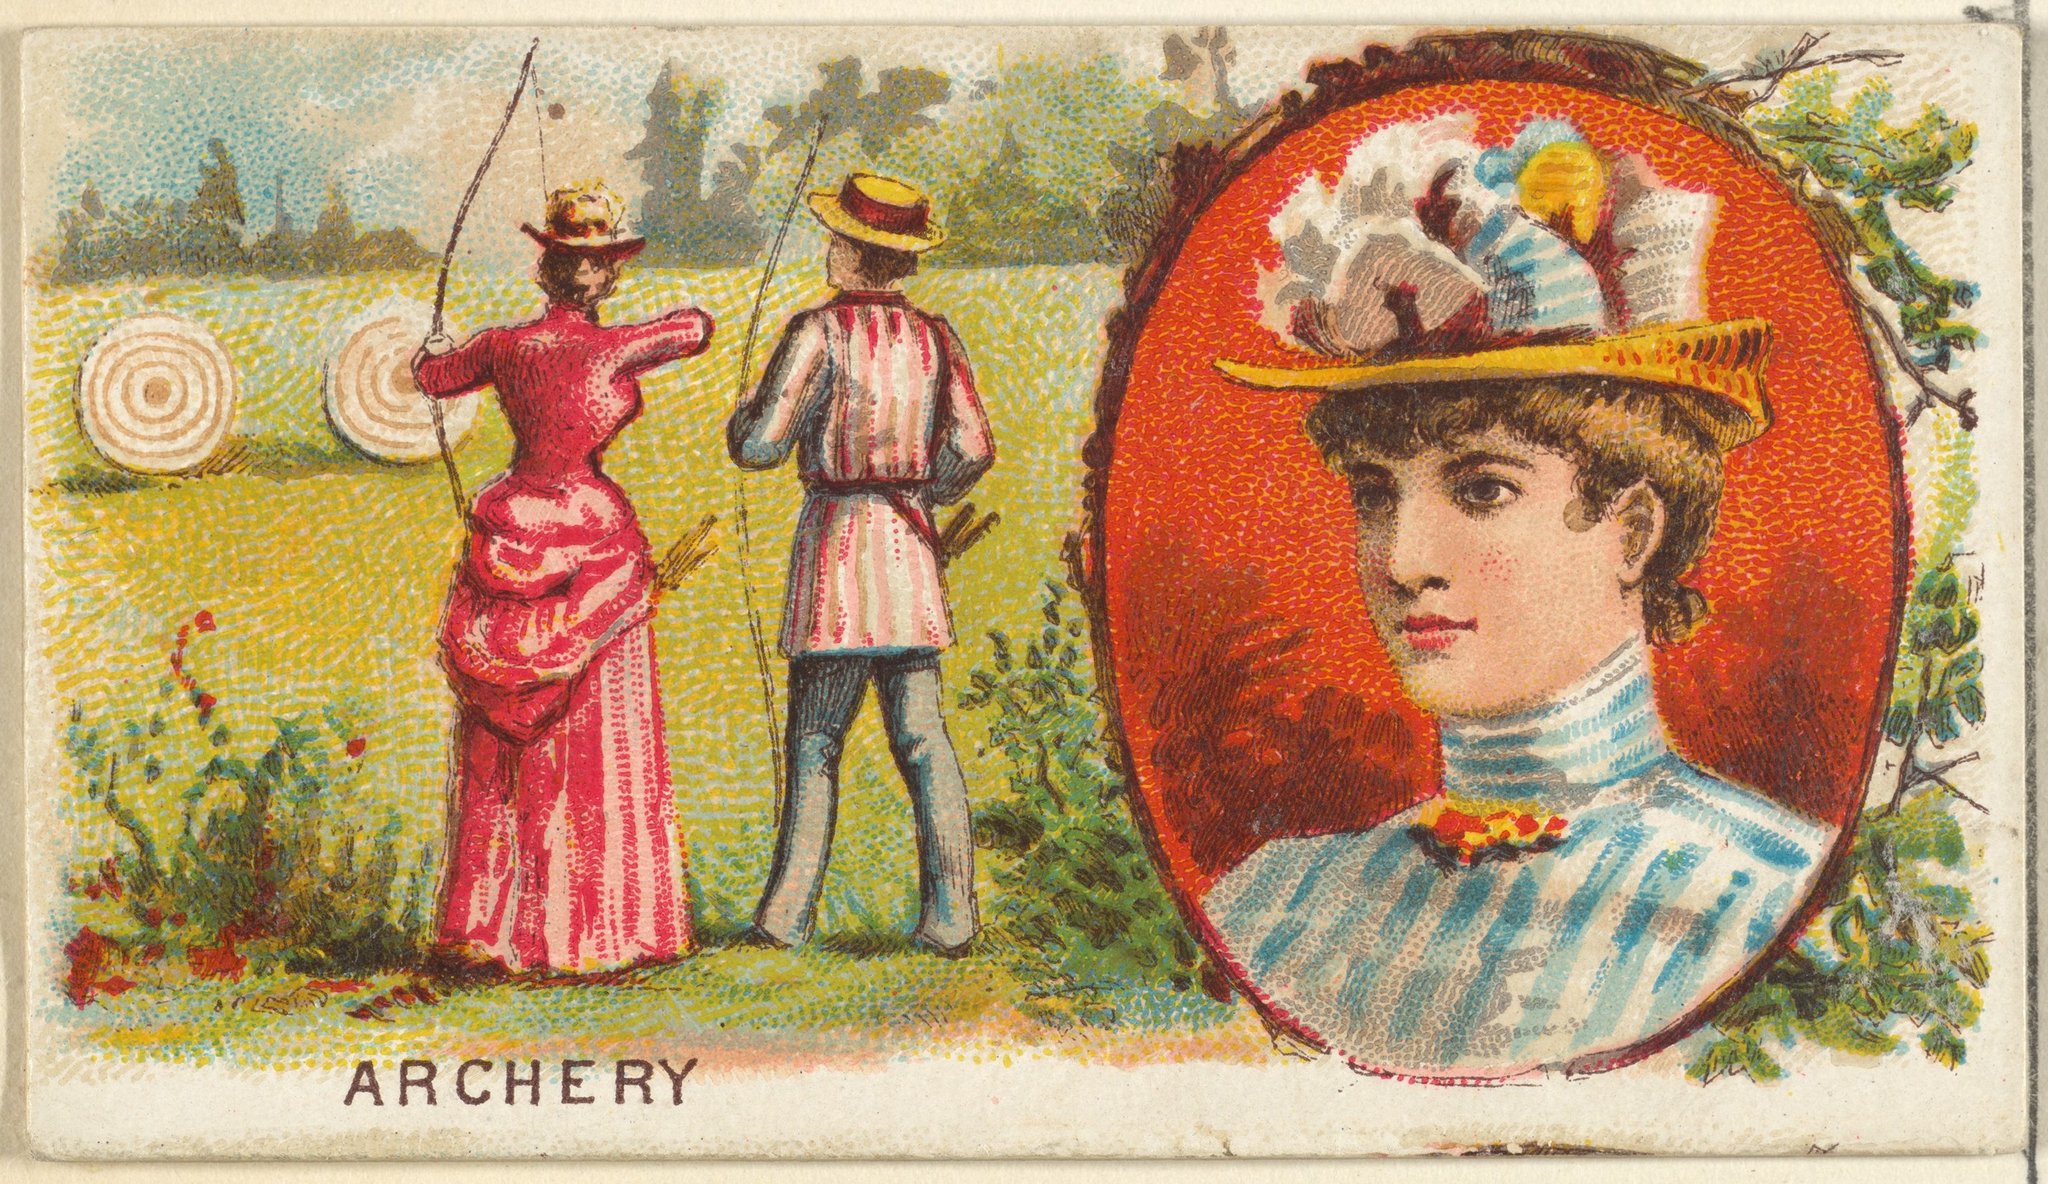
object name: print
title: Archery, from the Games and Sports series (N165) for Old Judge Cigarettes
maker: goodwin & company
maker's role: publisher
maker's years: 1850-1950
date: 1889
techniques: color lithograph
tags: men,women,archery